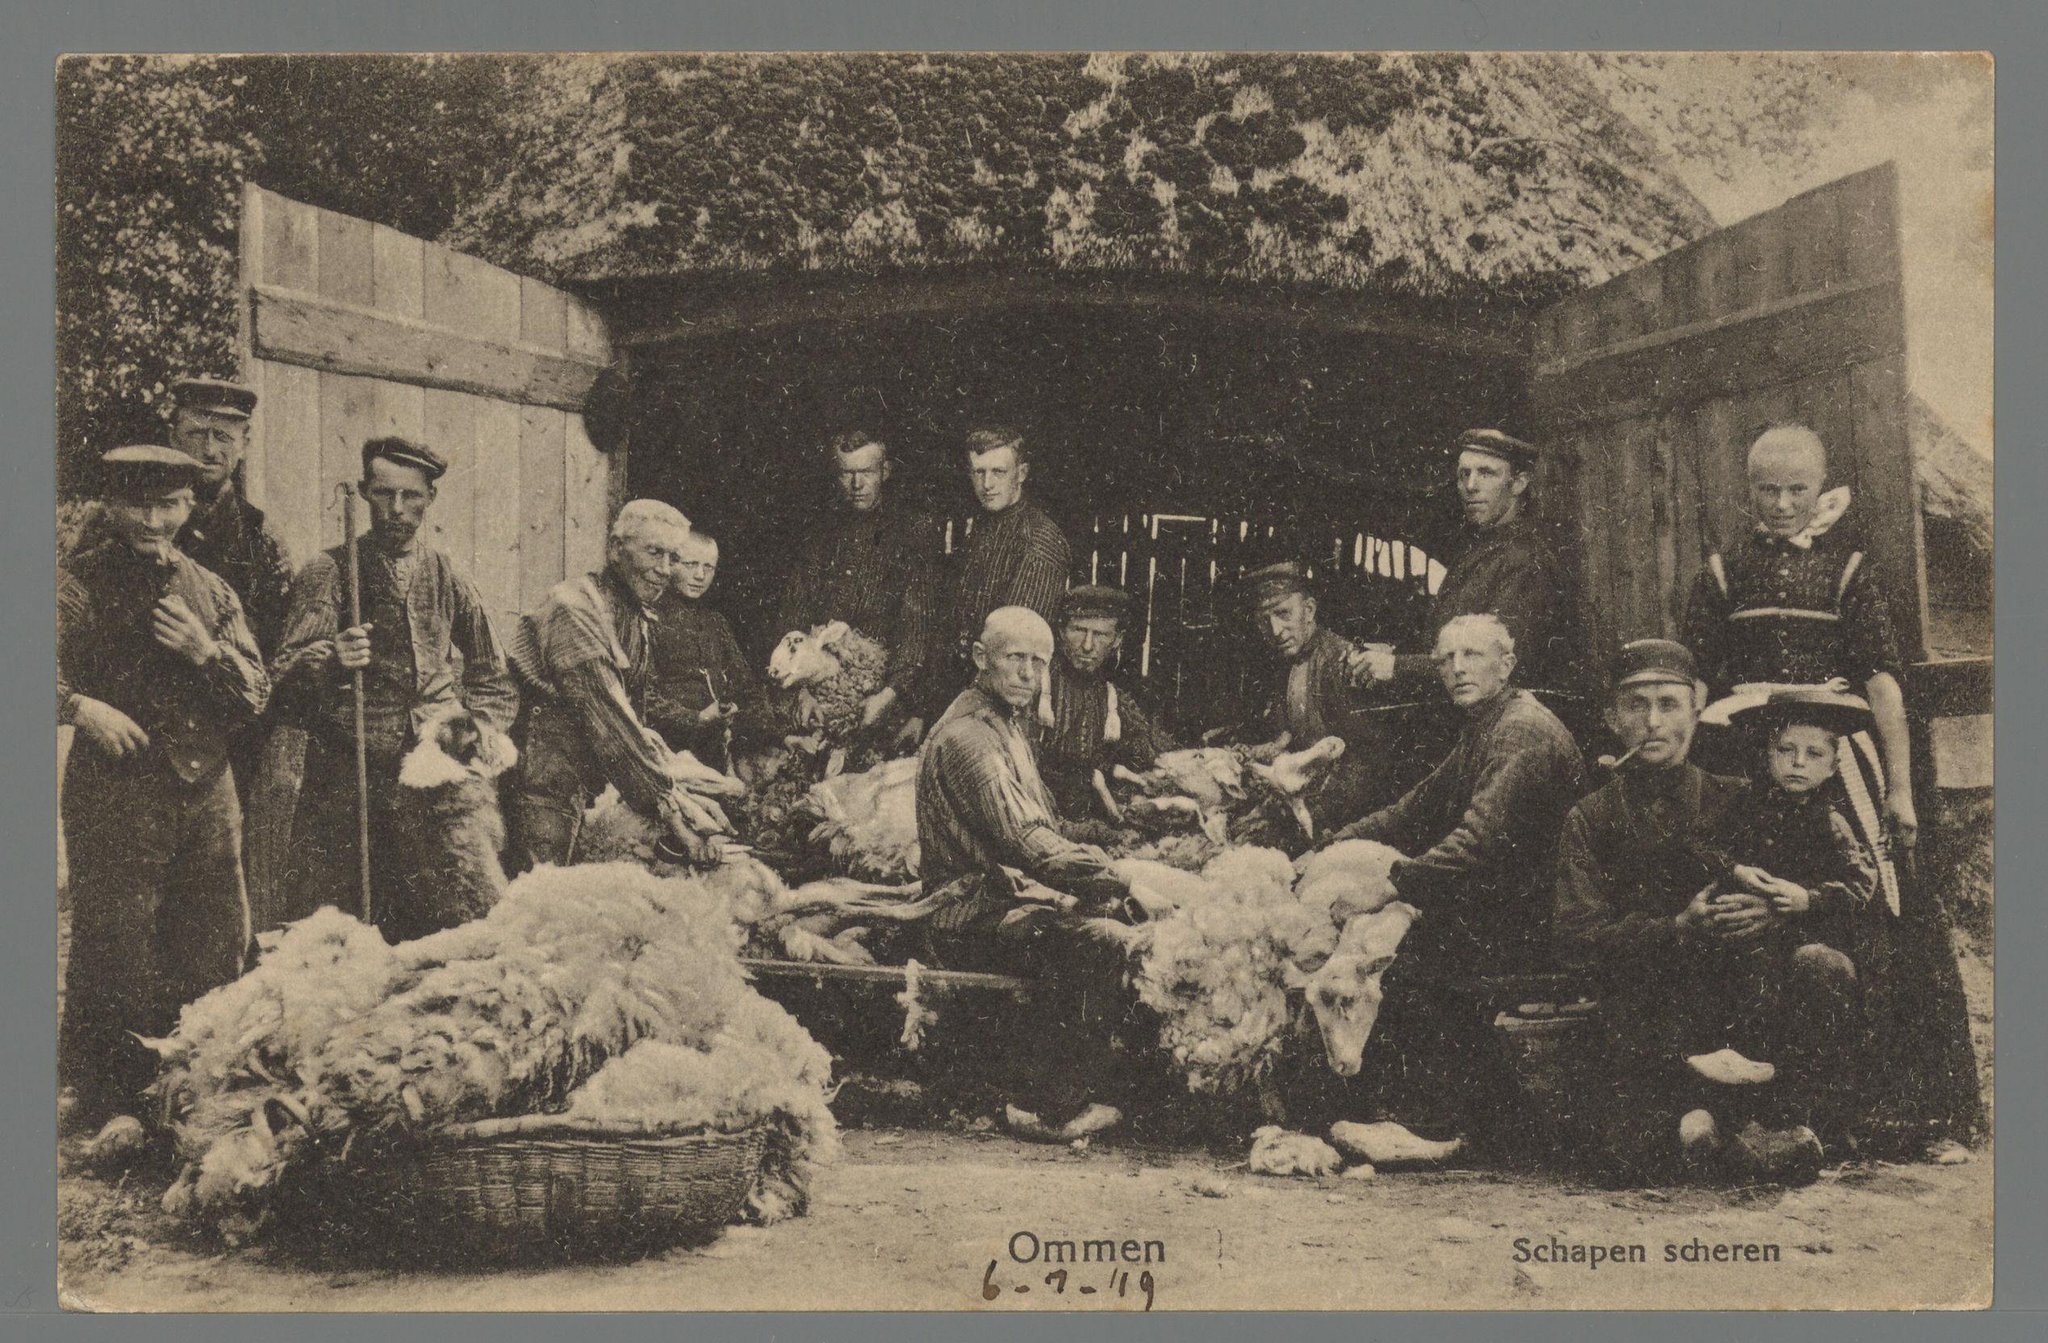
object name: photomechanical print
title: Ommen. Schapen scheren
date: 1917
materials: cardboard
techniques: photograph, writing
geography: ommen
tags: farmers, shearing (sheep)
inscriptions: postage stamp